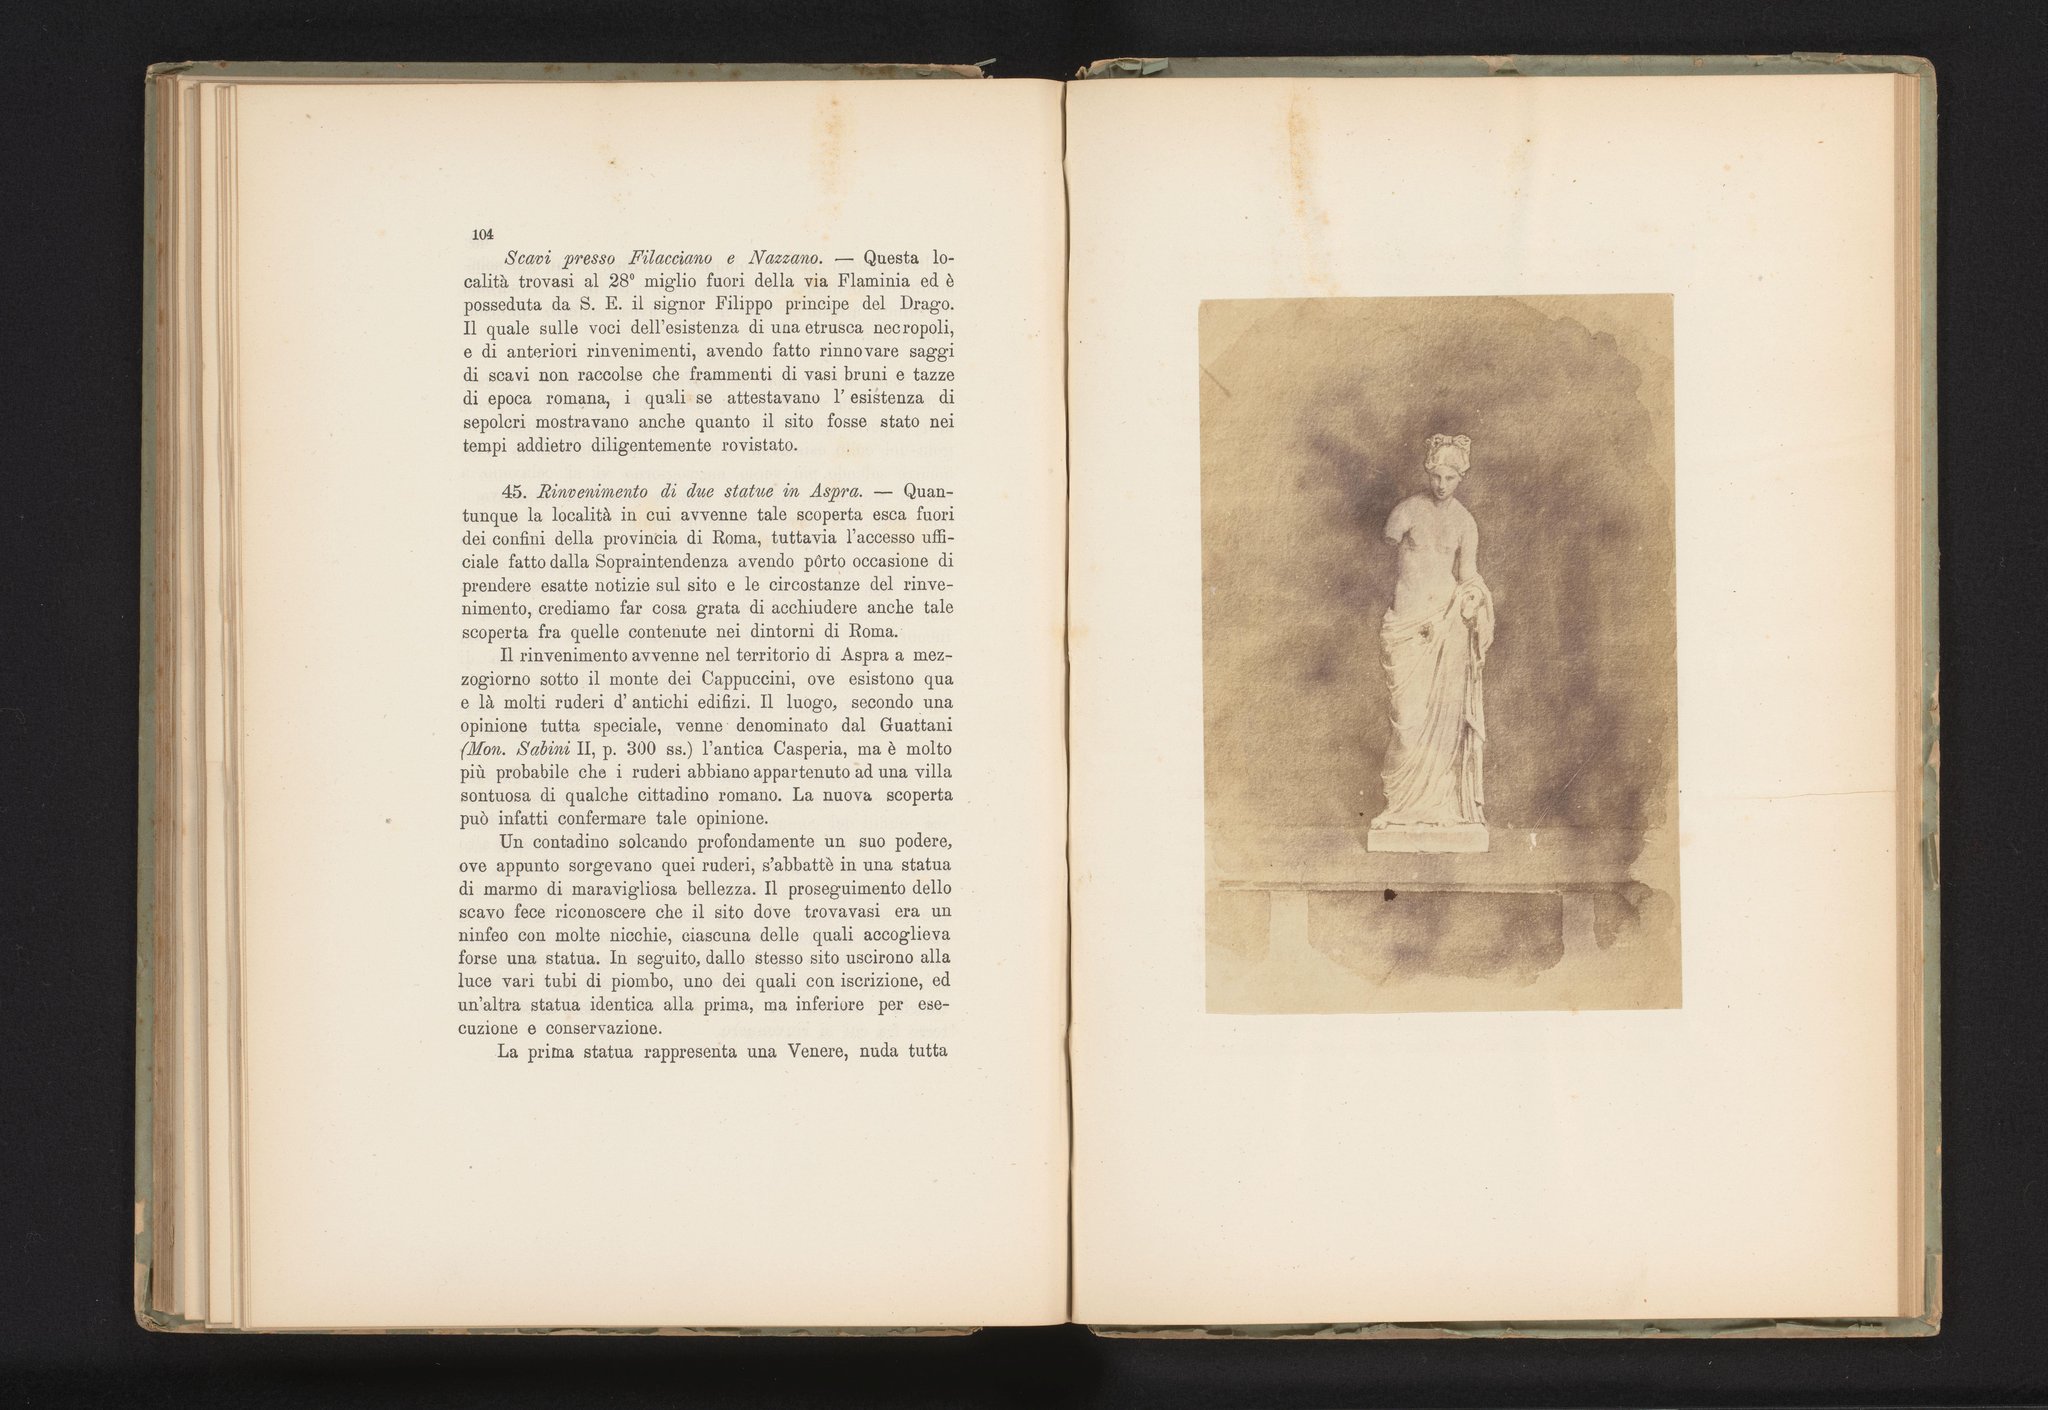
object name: page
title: Fotoreproductie van een schilderij, voorstellende een sculptuur van Venus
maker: Anonymous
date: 1863-1873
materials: photographic support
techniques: albumen print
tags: bath of venus, sculpture